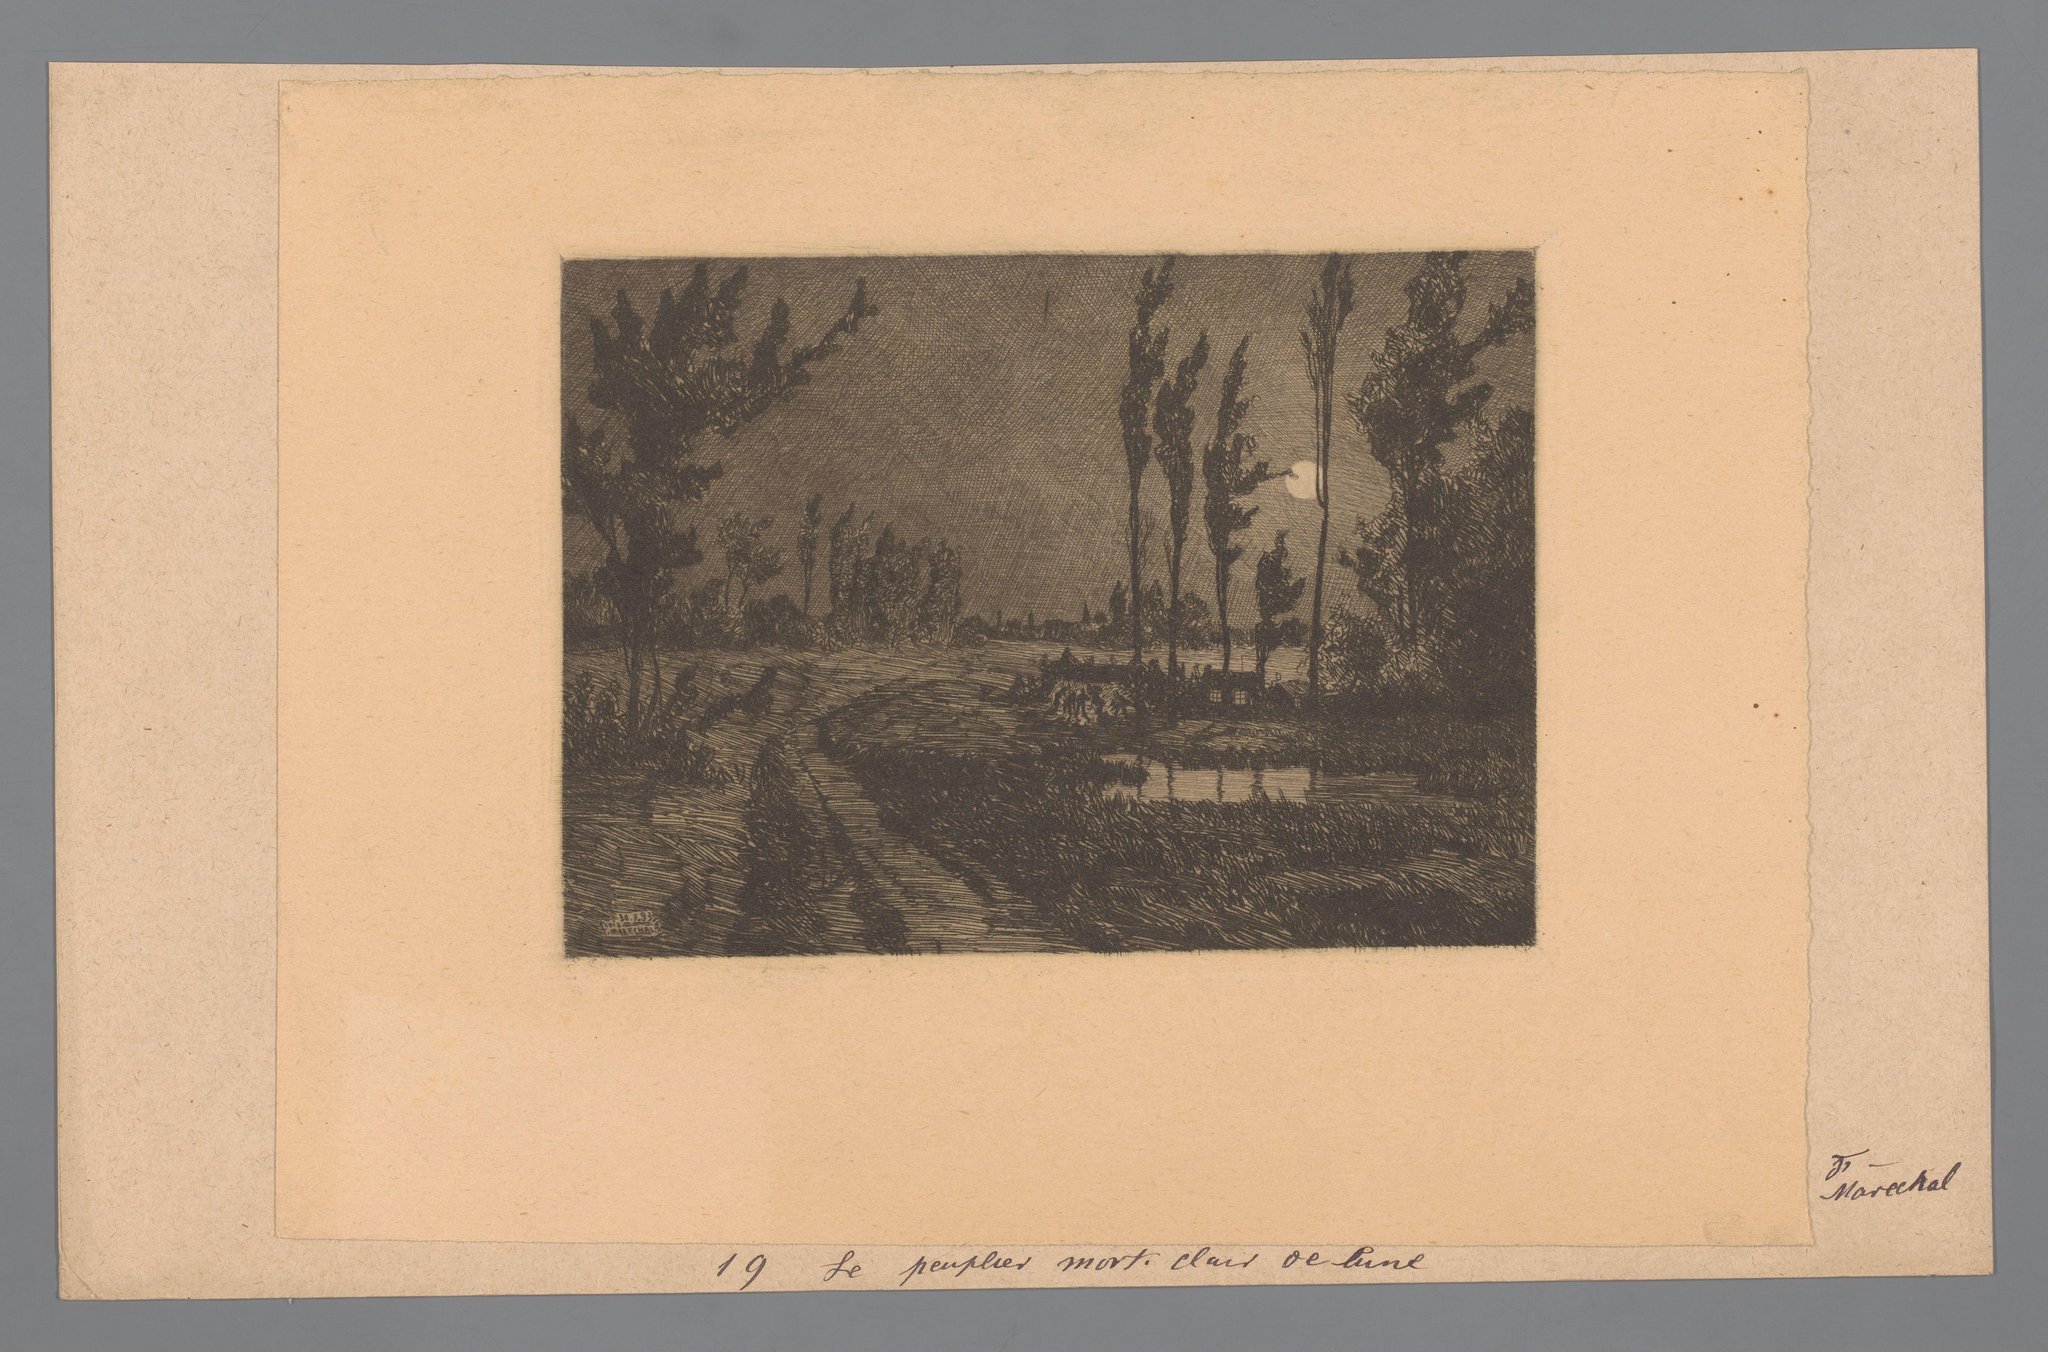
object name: print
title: Landschap met populieren in maanlicht en figuren rondom een vuur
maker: françois maréchal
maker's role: print maker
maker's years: 1861-1945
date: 1893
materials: paper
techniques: etching, intaglio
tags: landscapes, trees: poplar, moonlight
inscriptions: collector's mark: Lugt 2228